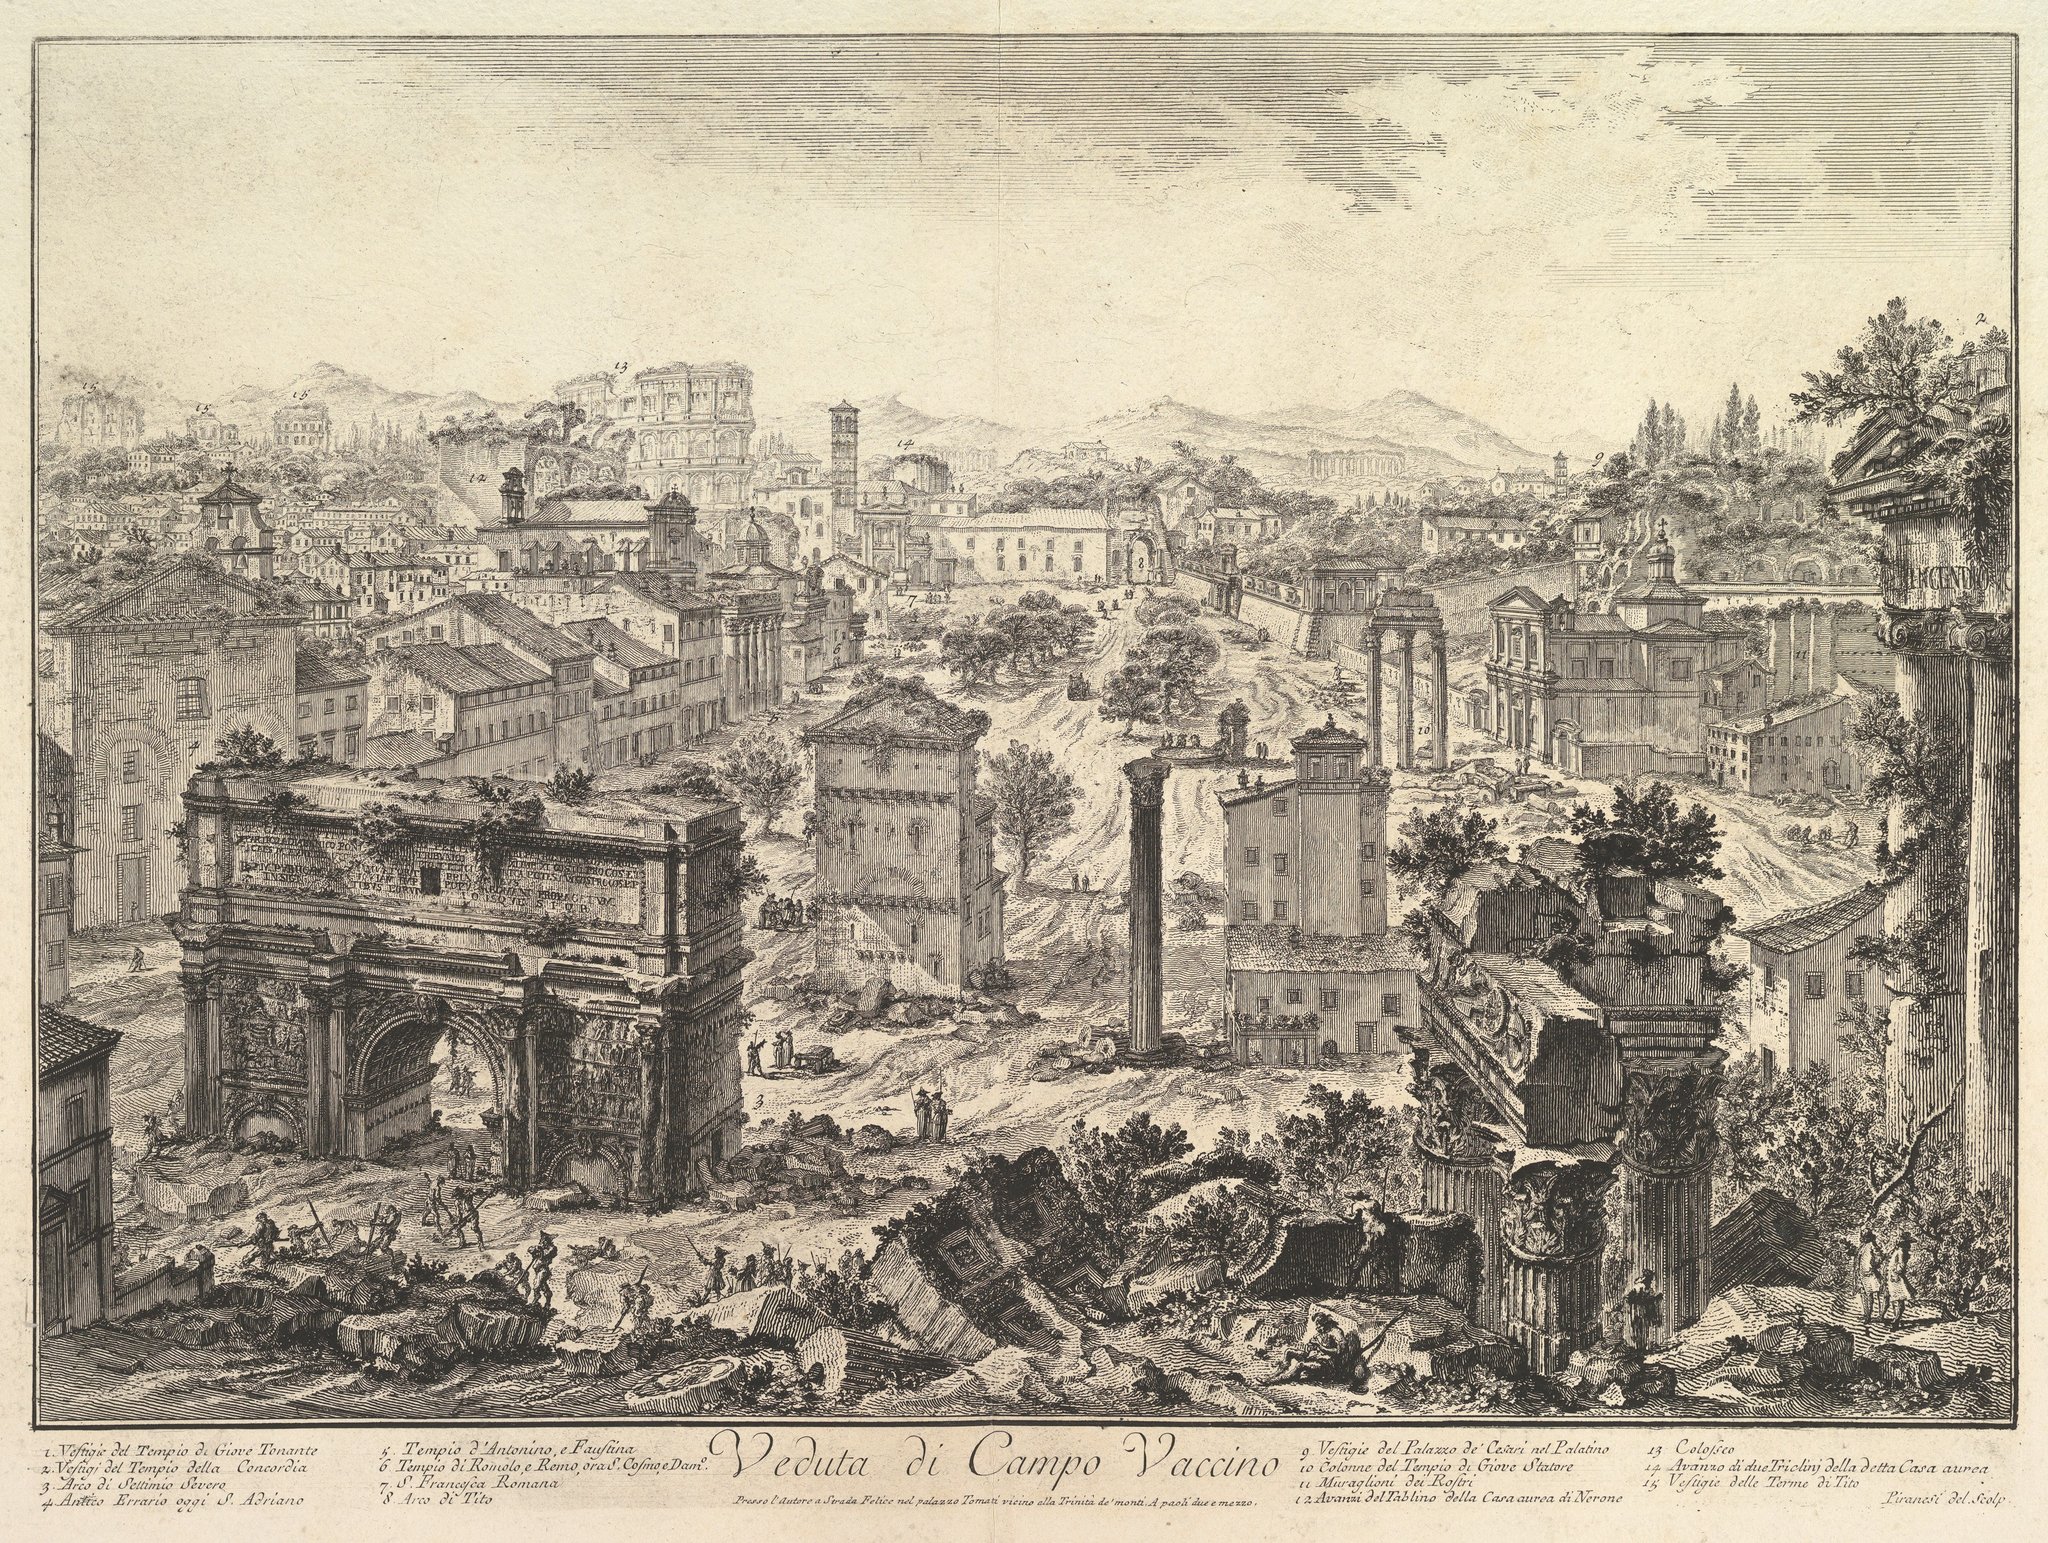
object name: print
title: The Forum Romanum, or Campo Vaccino, from the Capitol, with the Arch of Septimius in the foreground left, Temple of Vespian right, and the Colosseum in the distance (Veduta di Campo Vaccino)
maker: giovanni battista piranesi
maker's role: artist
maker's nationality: italian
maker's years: 1720-1778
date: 1775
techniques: etching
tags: buildings,cities,ruins